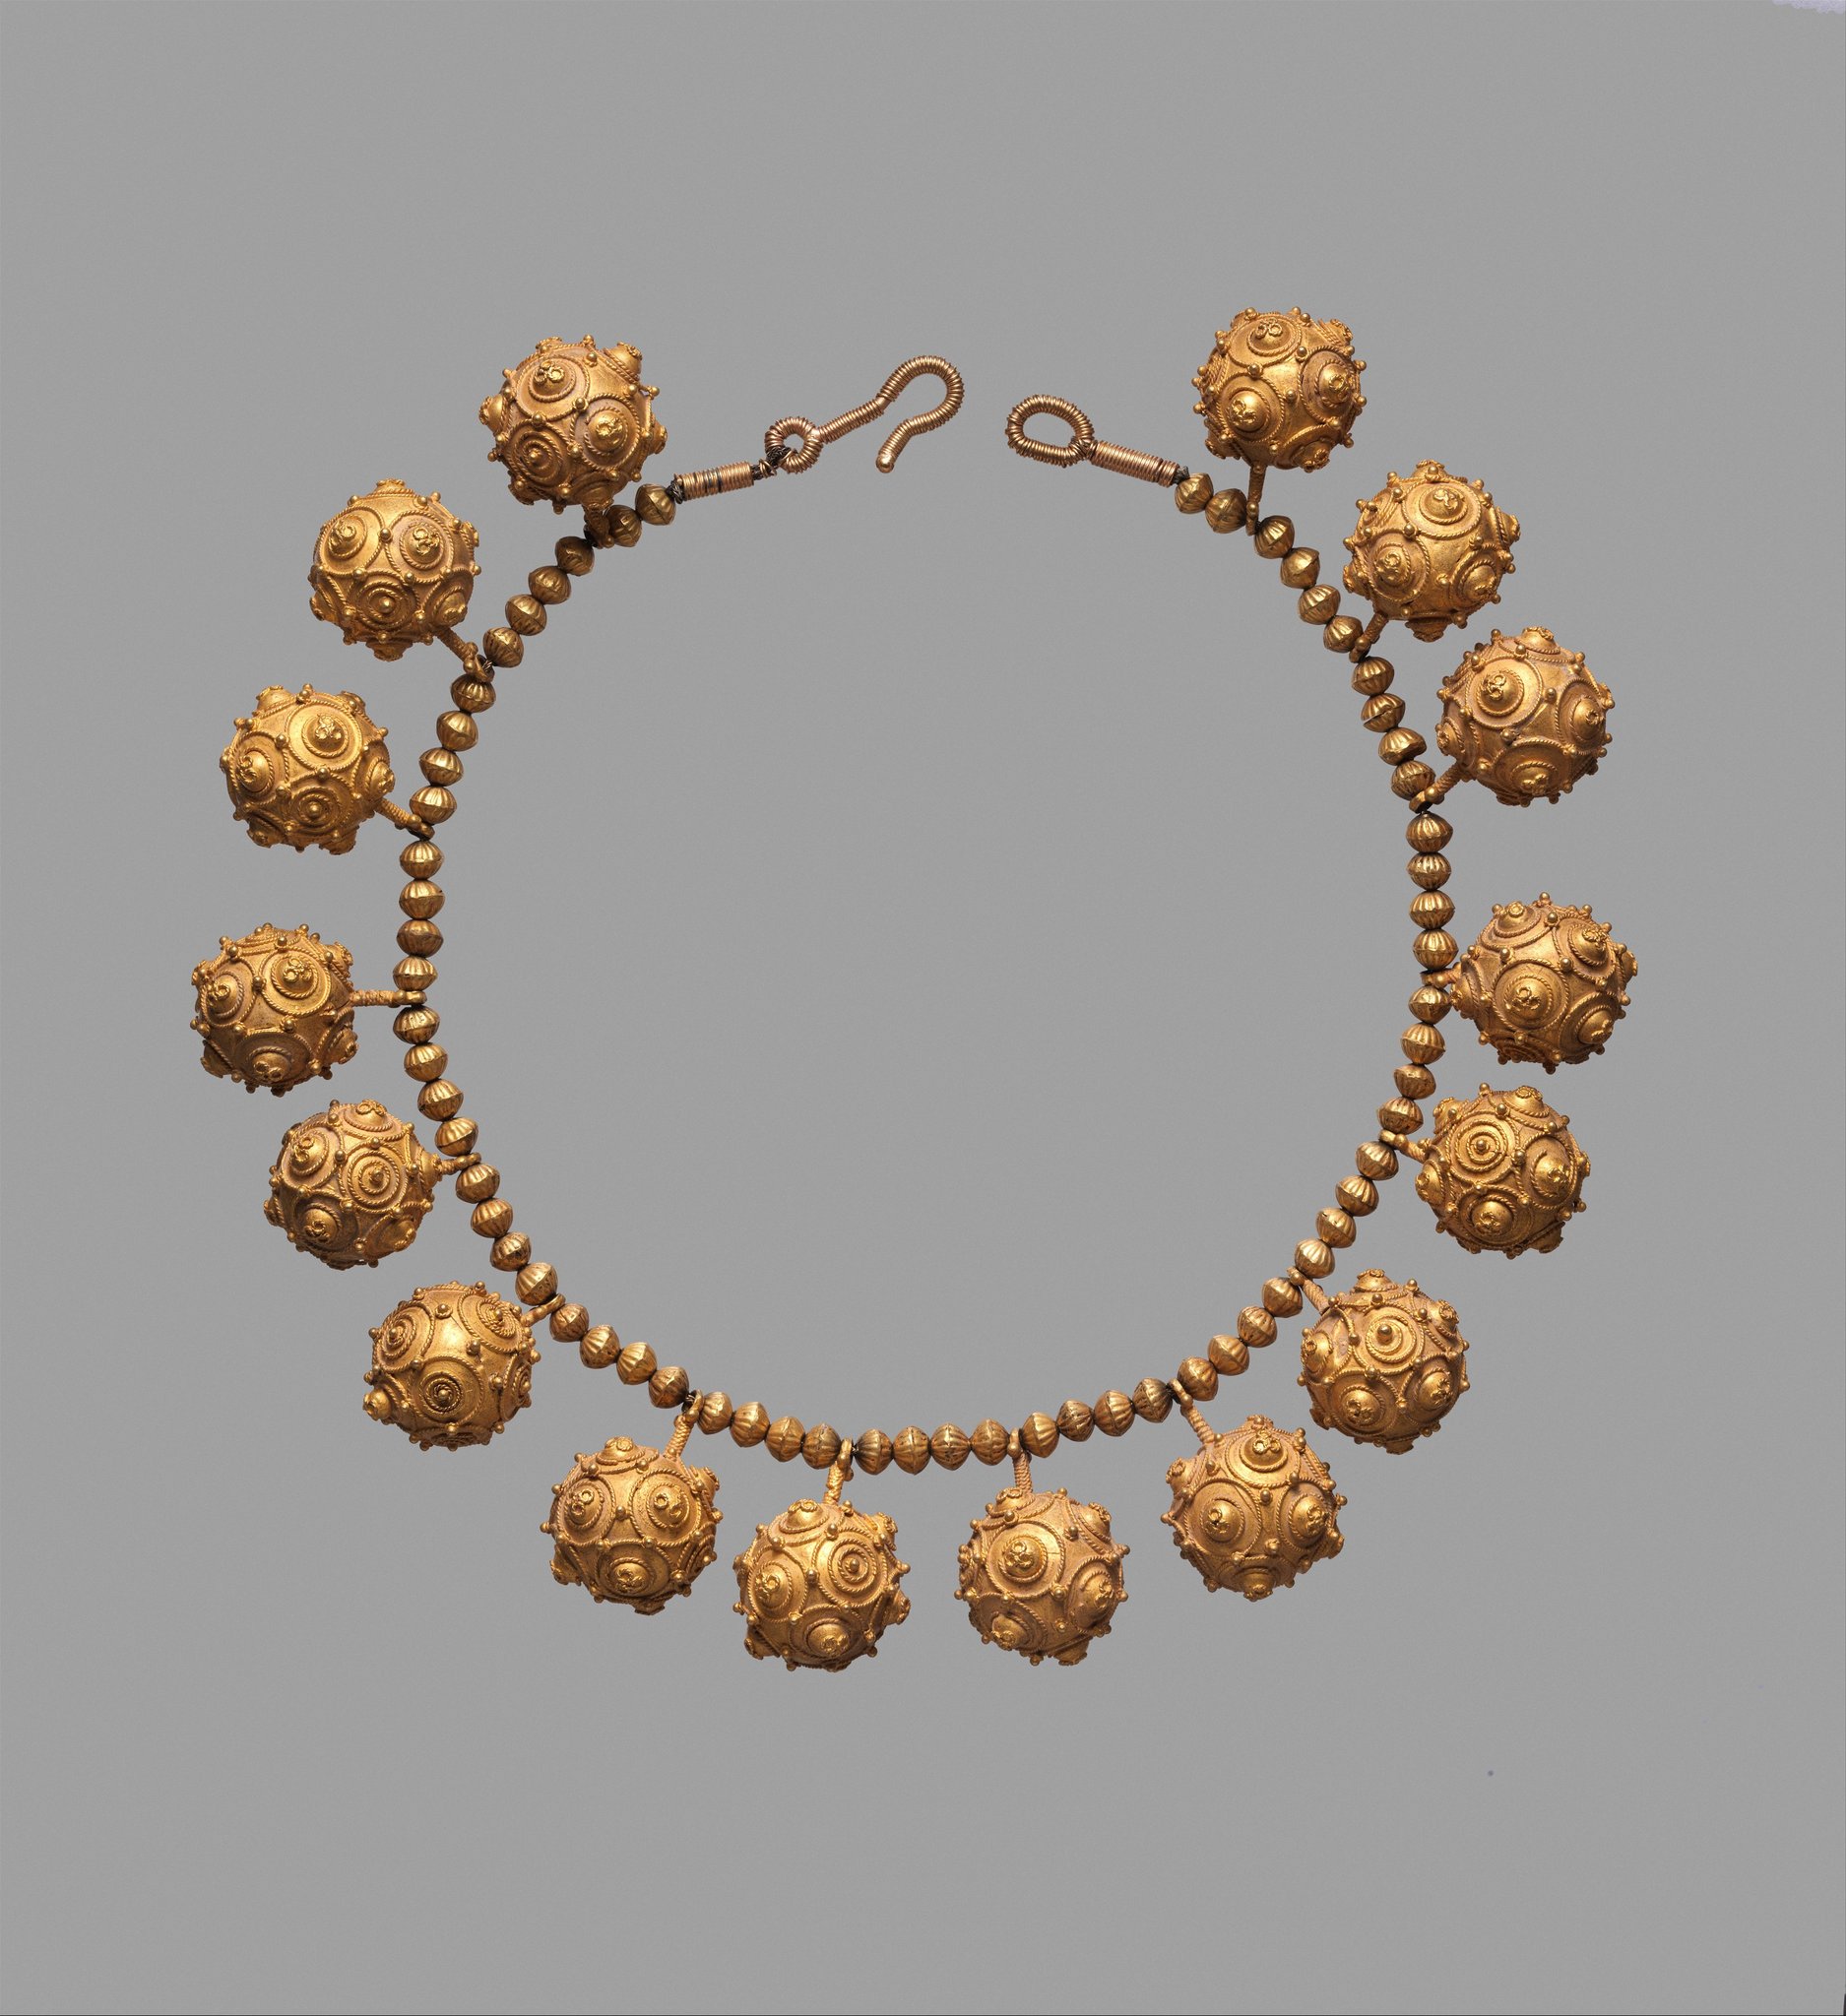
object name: necklace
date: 1001-1100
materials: gold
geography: iran